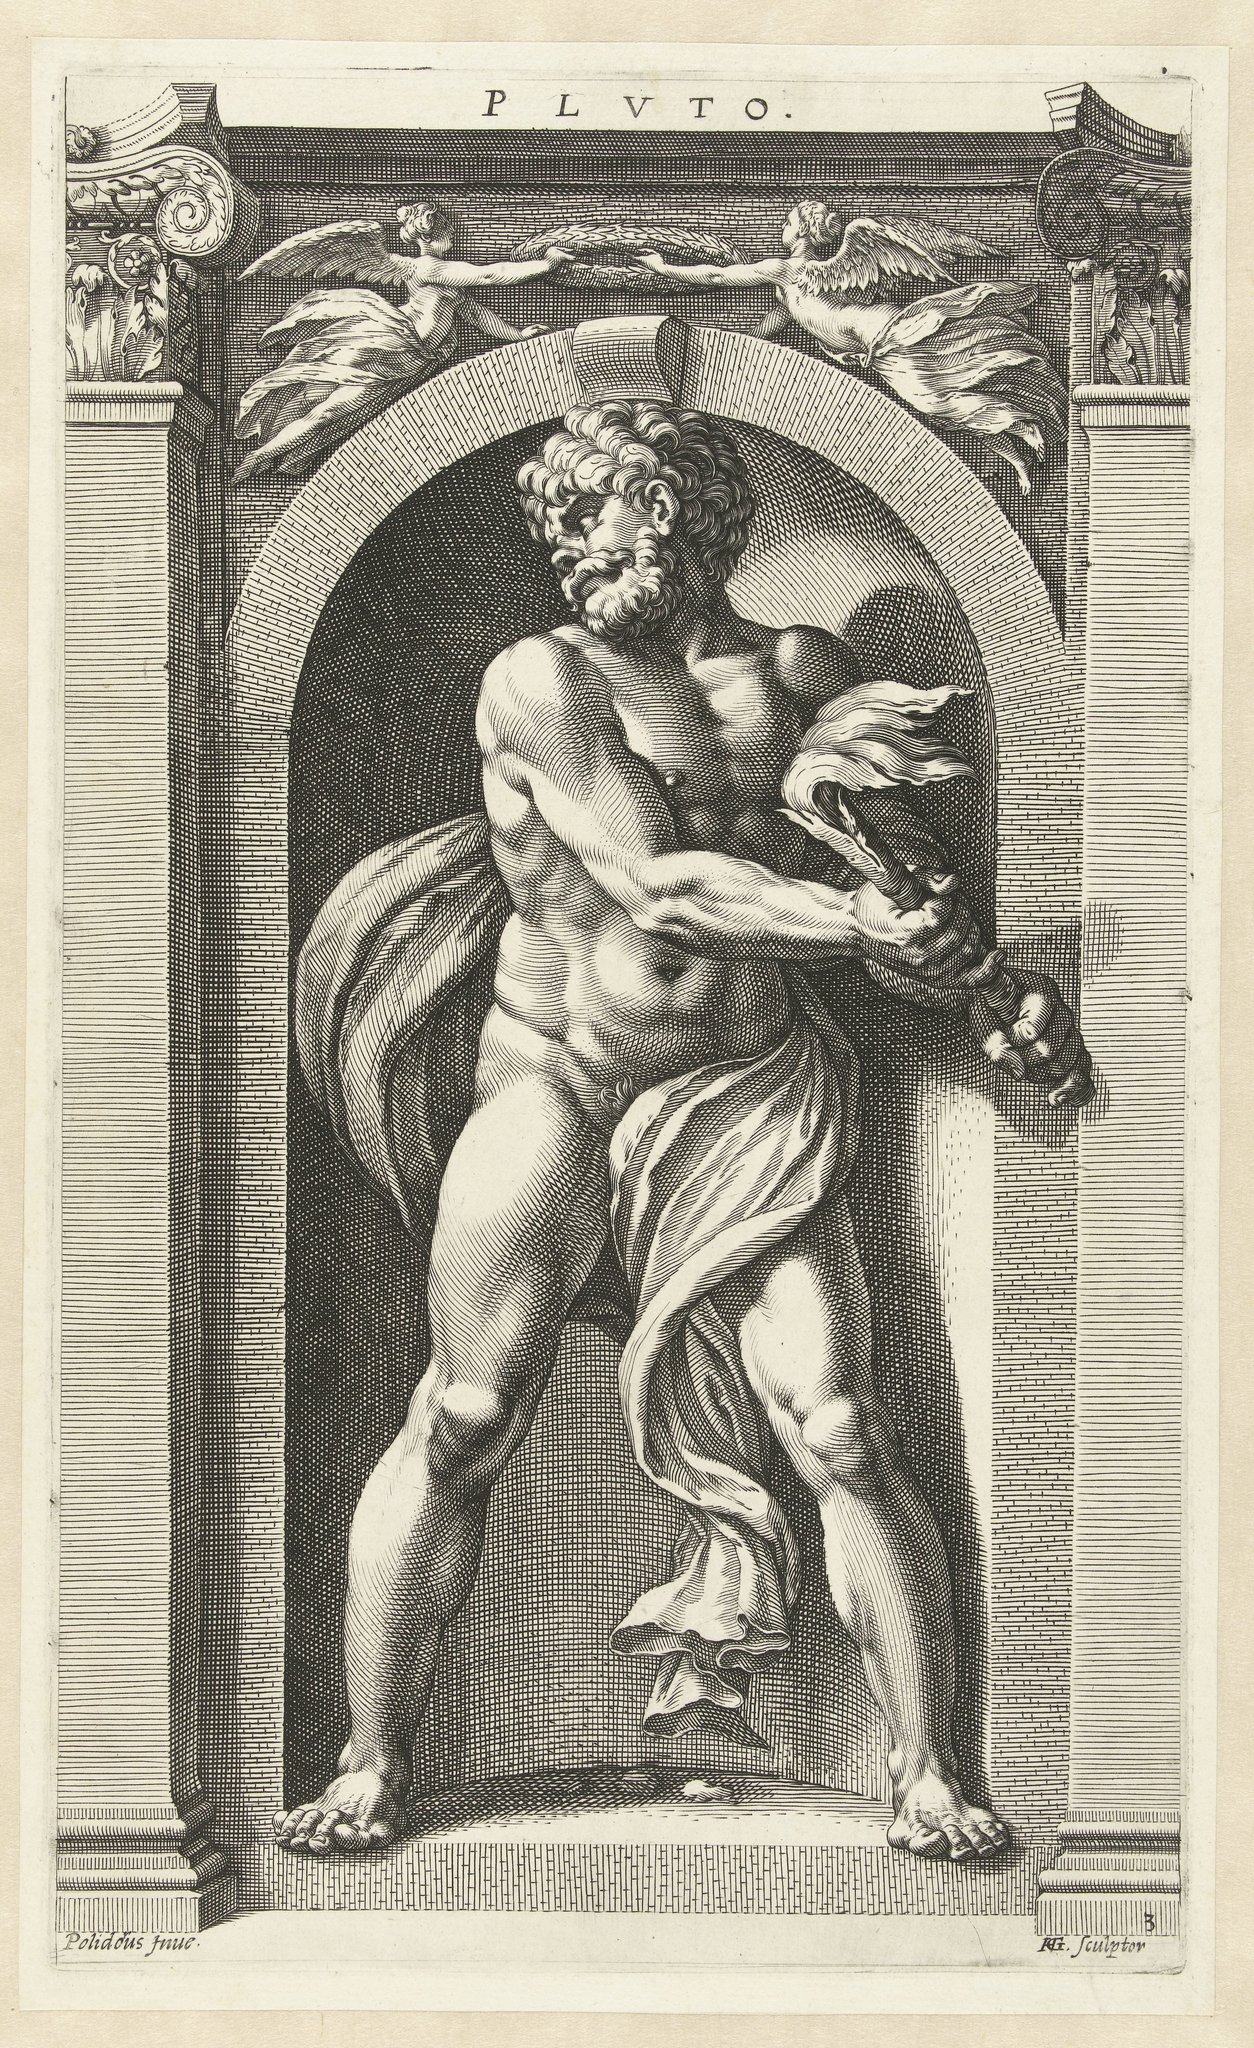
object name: print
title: Acht klassieke goden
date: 1592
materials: paper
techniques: engraving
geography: haarlem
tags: (story of) pluto (hades), dis pater, orcus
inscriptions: collector's mark: Lugt 240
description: Pluto, staand in een nis, een brandende toorts in zijn handen. Deze prent is onderdeel van een serie van acht prenten van klassieke goden, gebaseerd op schilderingen van Polidoro da Caravaggio op de façade van een Romeins huis, door Goltzius in Rome gezien en nagetekend.